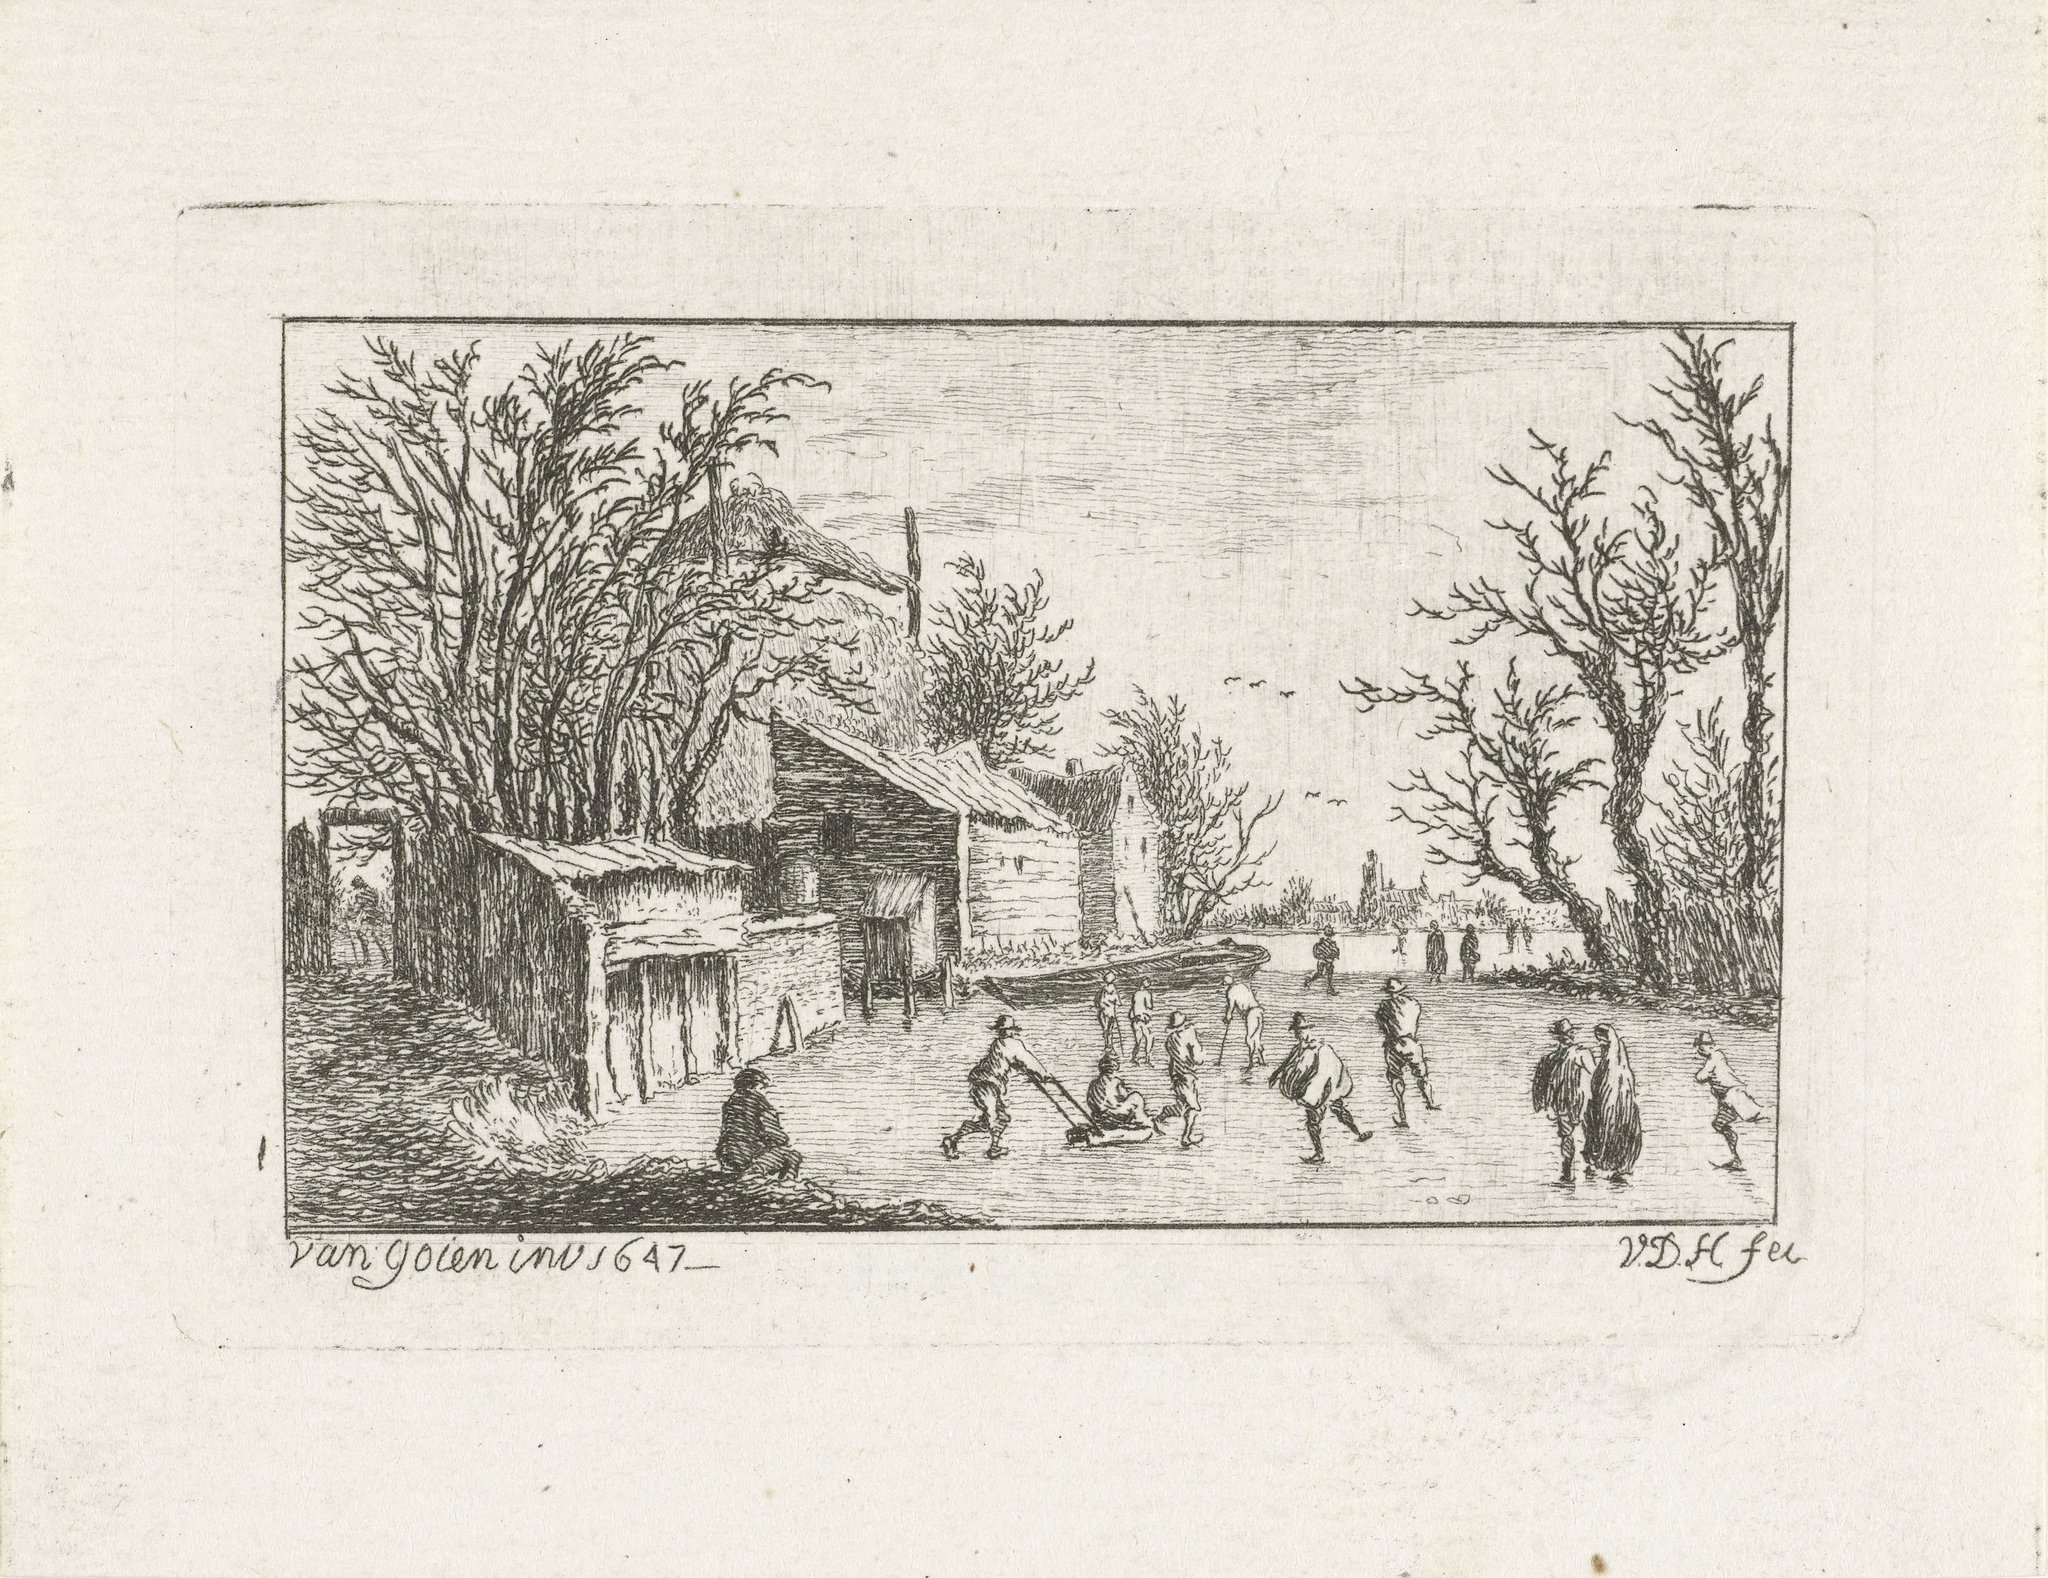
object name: print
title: Schaatsers bij een boerderij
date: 1745-1785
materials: paper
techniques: etching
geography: northern netherlands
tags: skates (winter sports), farm or solitary house in landscape, small sleigh (winter sports)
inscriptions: collector's mark: Lugt 240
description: Schaatsers en een slee op een bevroren rivier bij een boerderij.